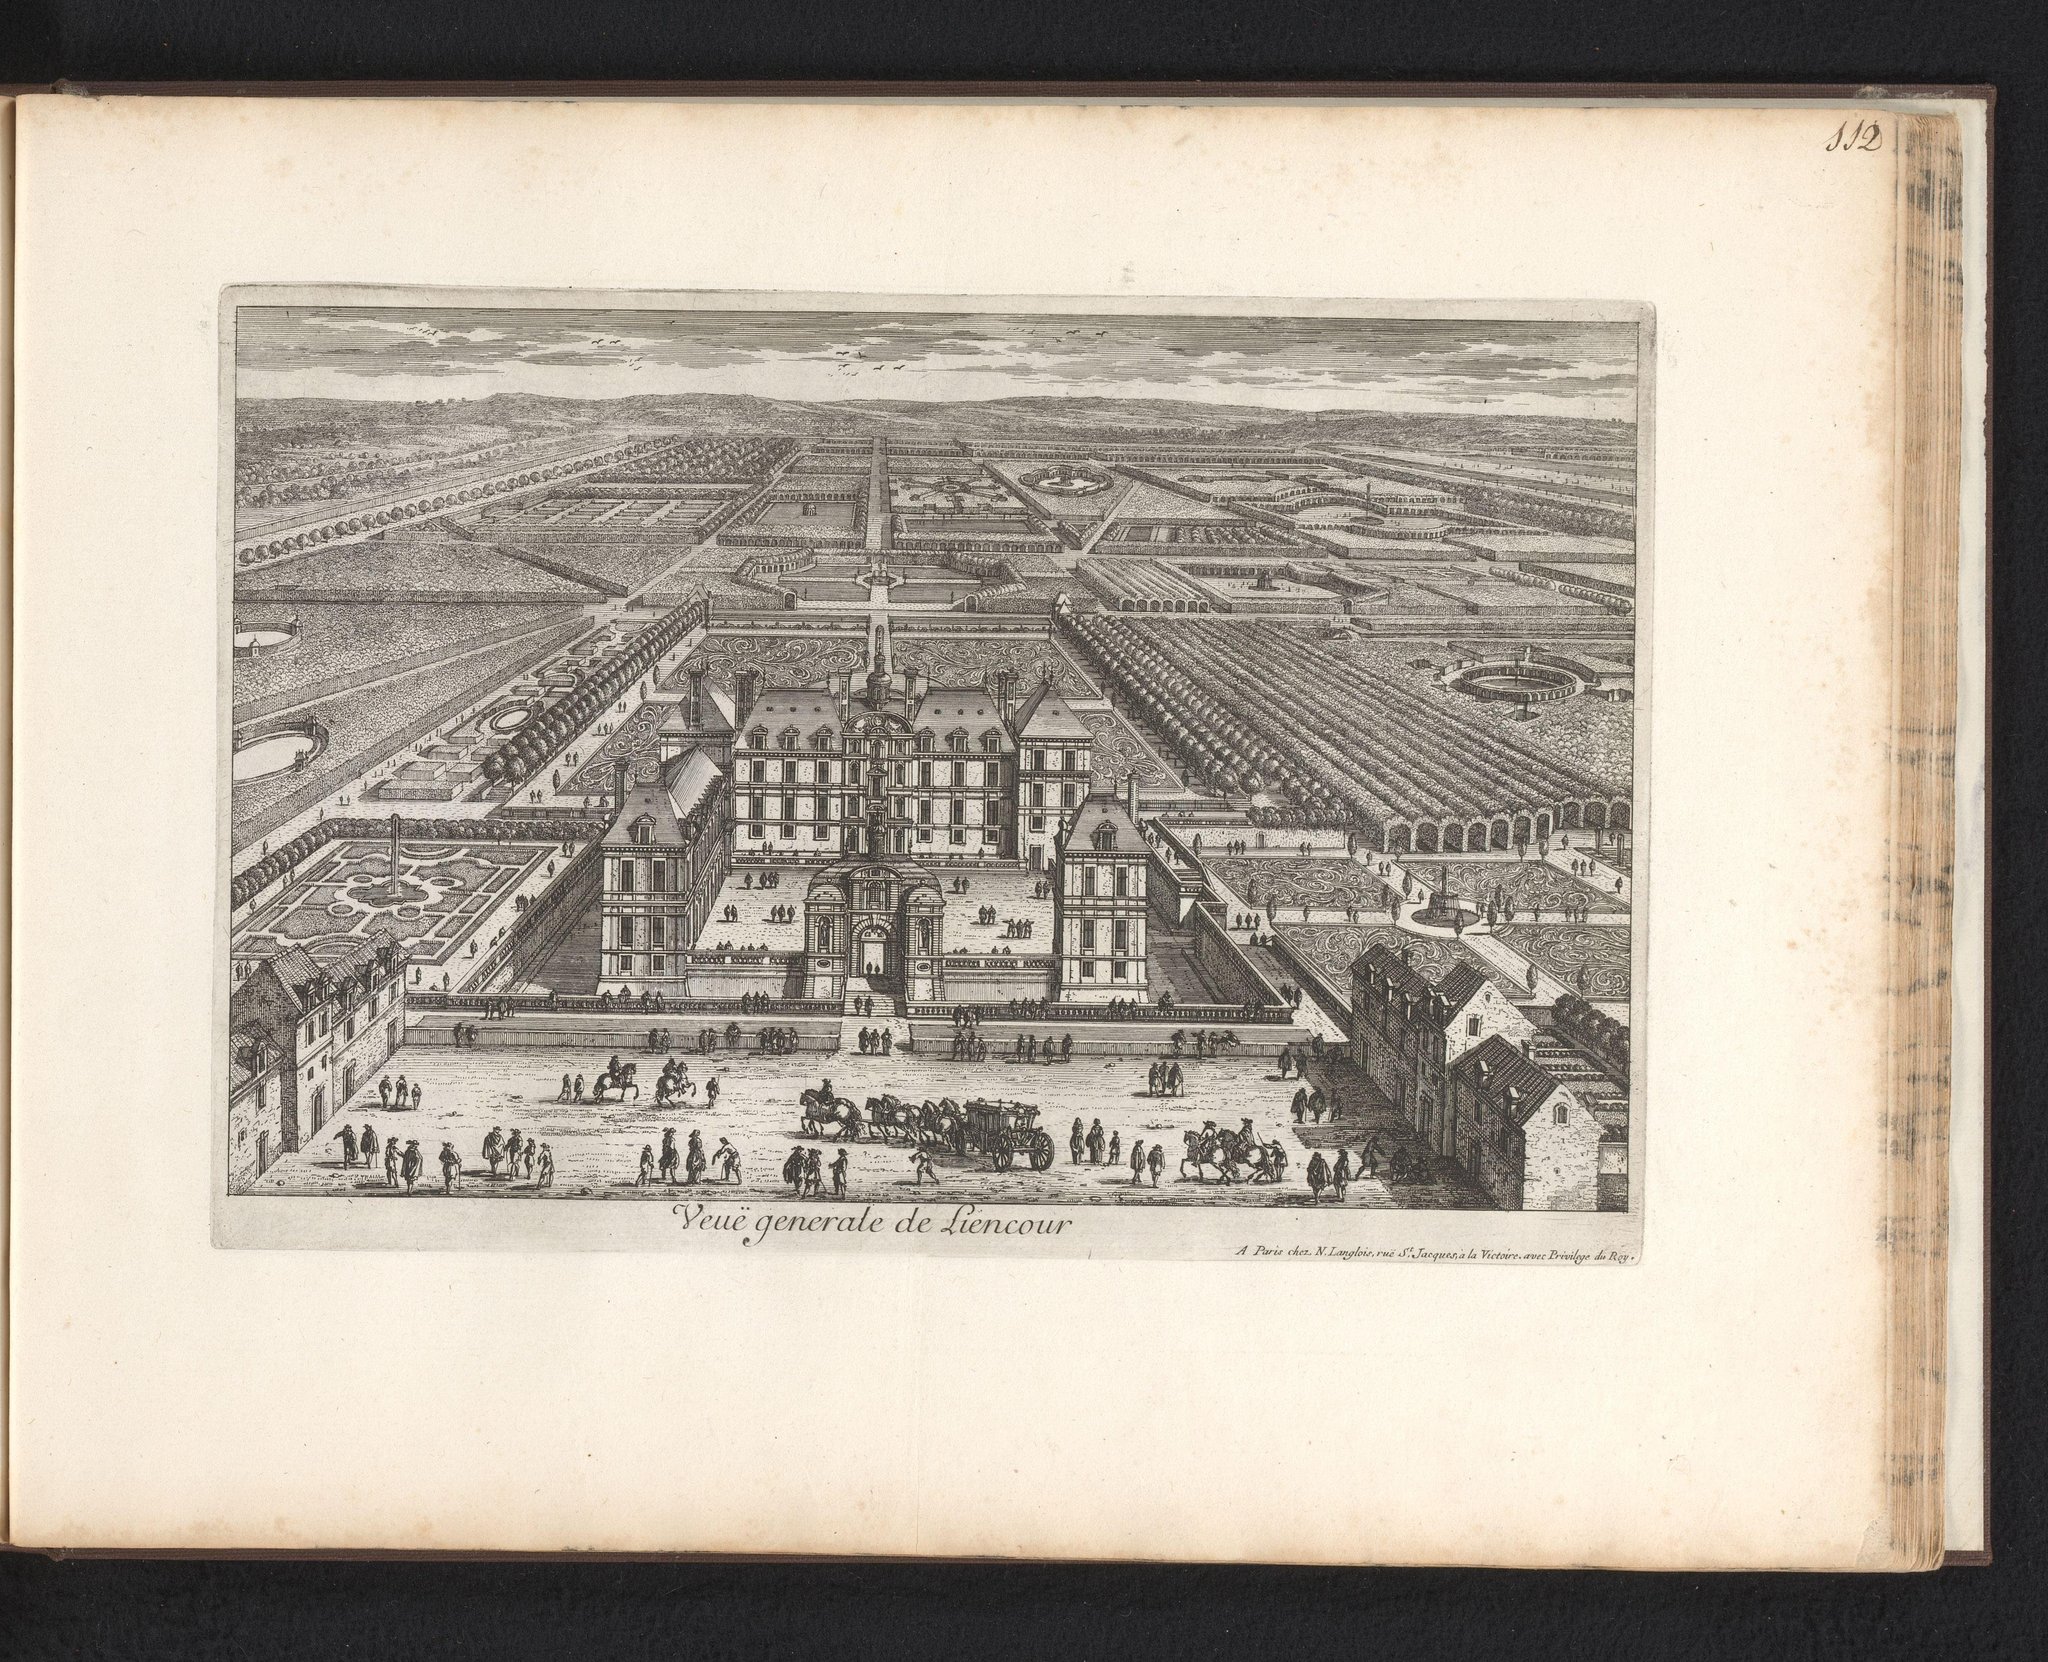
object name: album leaf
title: Veuë generale de Liencour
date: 1650-1695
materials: paper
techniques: etching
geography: france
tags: french or architectonic garden; formal garden, landscape with tower or castle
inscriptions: collector's mark: Lugt 2228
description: Prenten met het signatuur 'Perelle' kunnen zowel door vader Gabriel als door zonen Nicolas en Adam gemaakt zijn. De uitgevers vader en zoon Nicolas Langlois worden allebei vermeld als N. Langlois op hetzelfde adres.